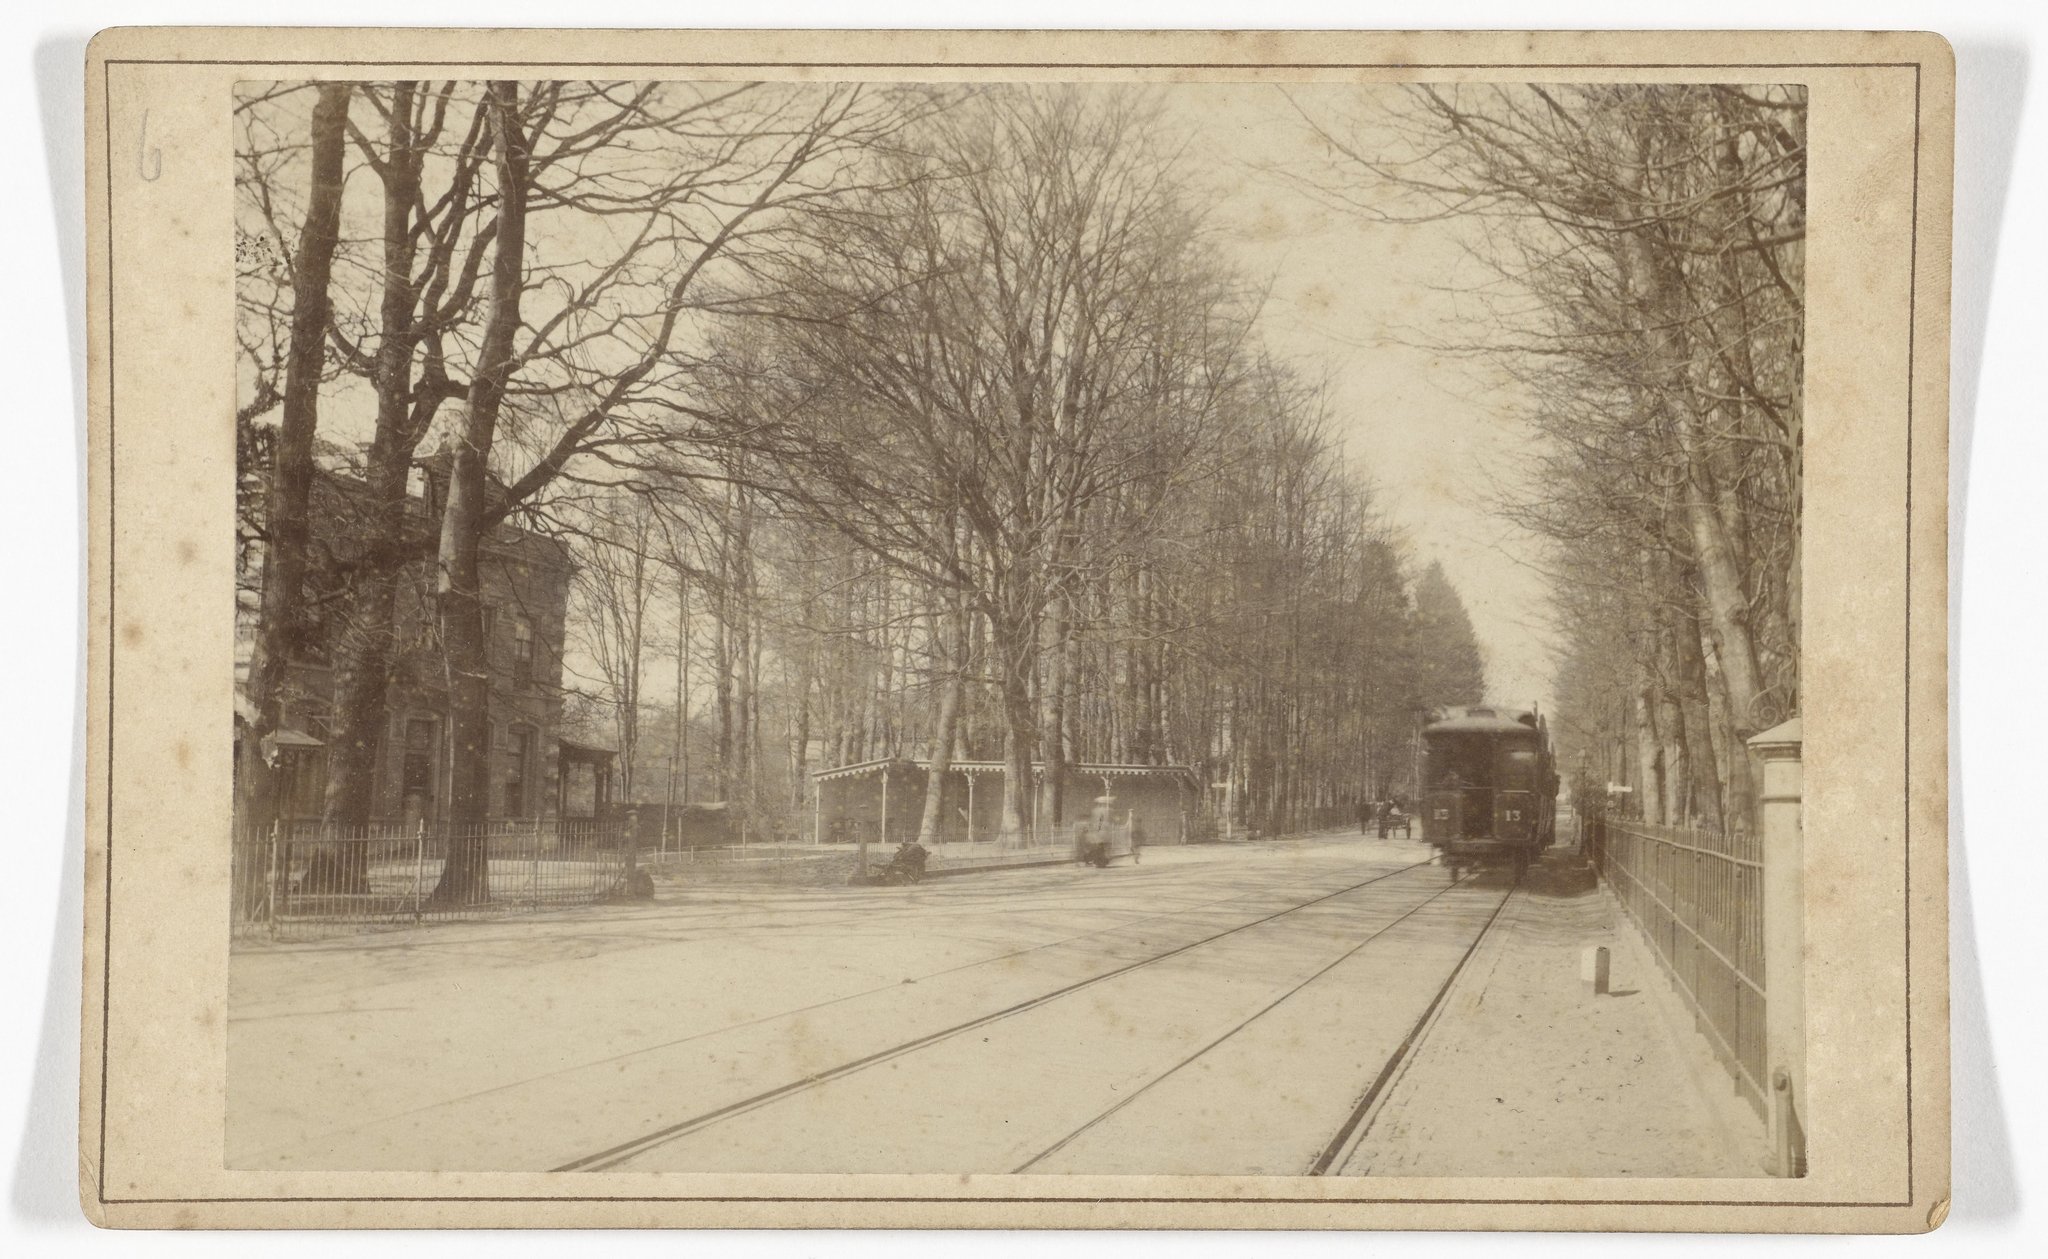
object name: photograph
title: Hôtel Schoonoord. Oosterbeek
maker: j.s.j. de jongh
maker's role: fotograaf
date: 1860-1880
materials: cardboard, paper, photographic support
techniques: albumen print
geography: arnhem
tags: diligence, omnibus, horse-tram, railway, tramway; rack railway, hotel, hostelry, inn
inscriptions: signature: ‘De Jongh, Koningsstraat 85 Arnhem’, annotation: ‘Hôtel Schoonoord. Oosterbeek’, signature: ‘Vosmaer’